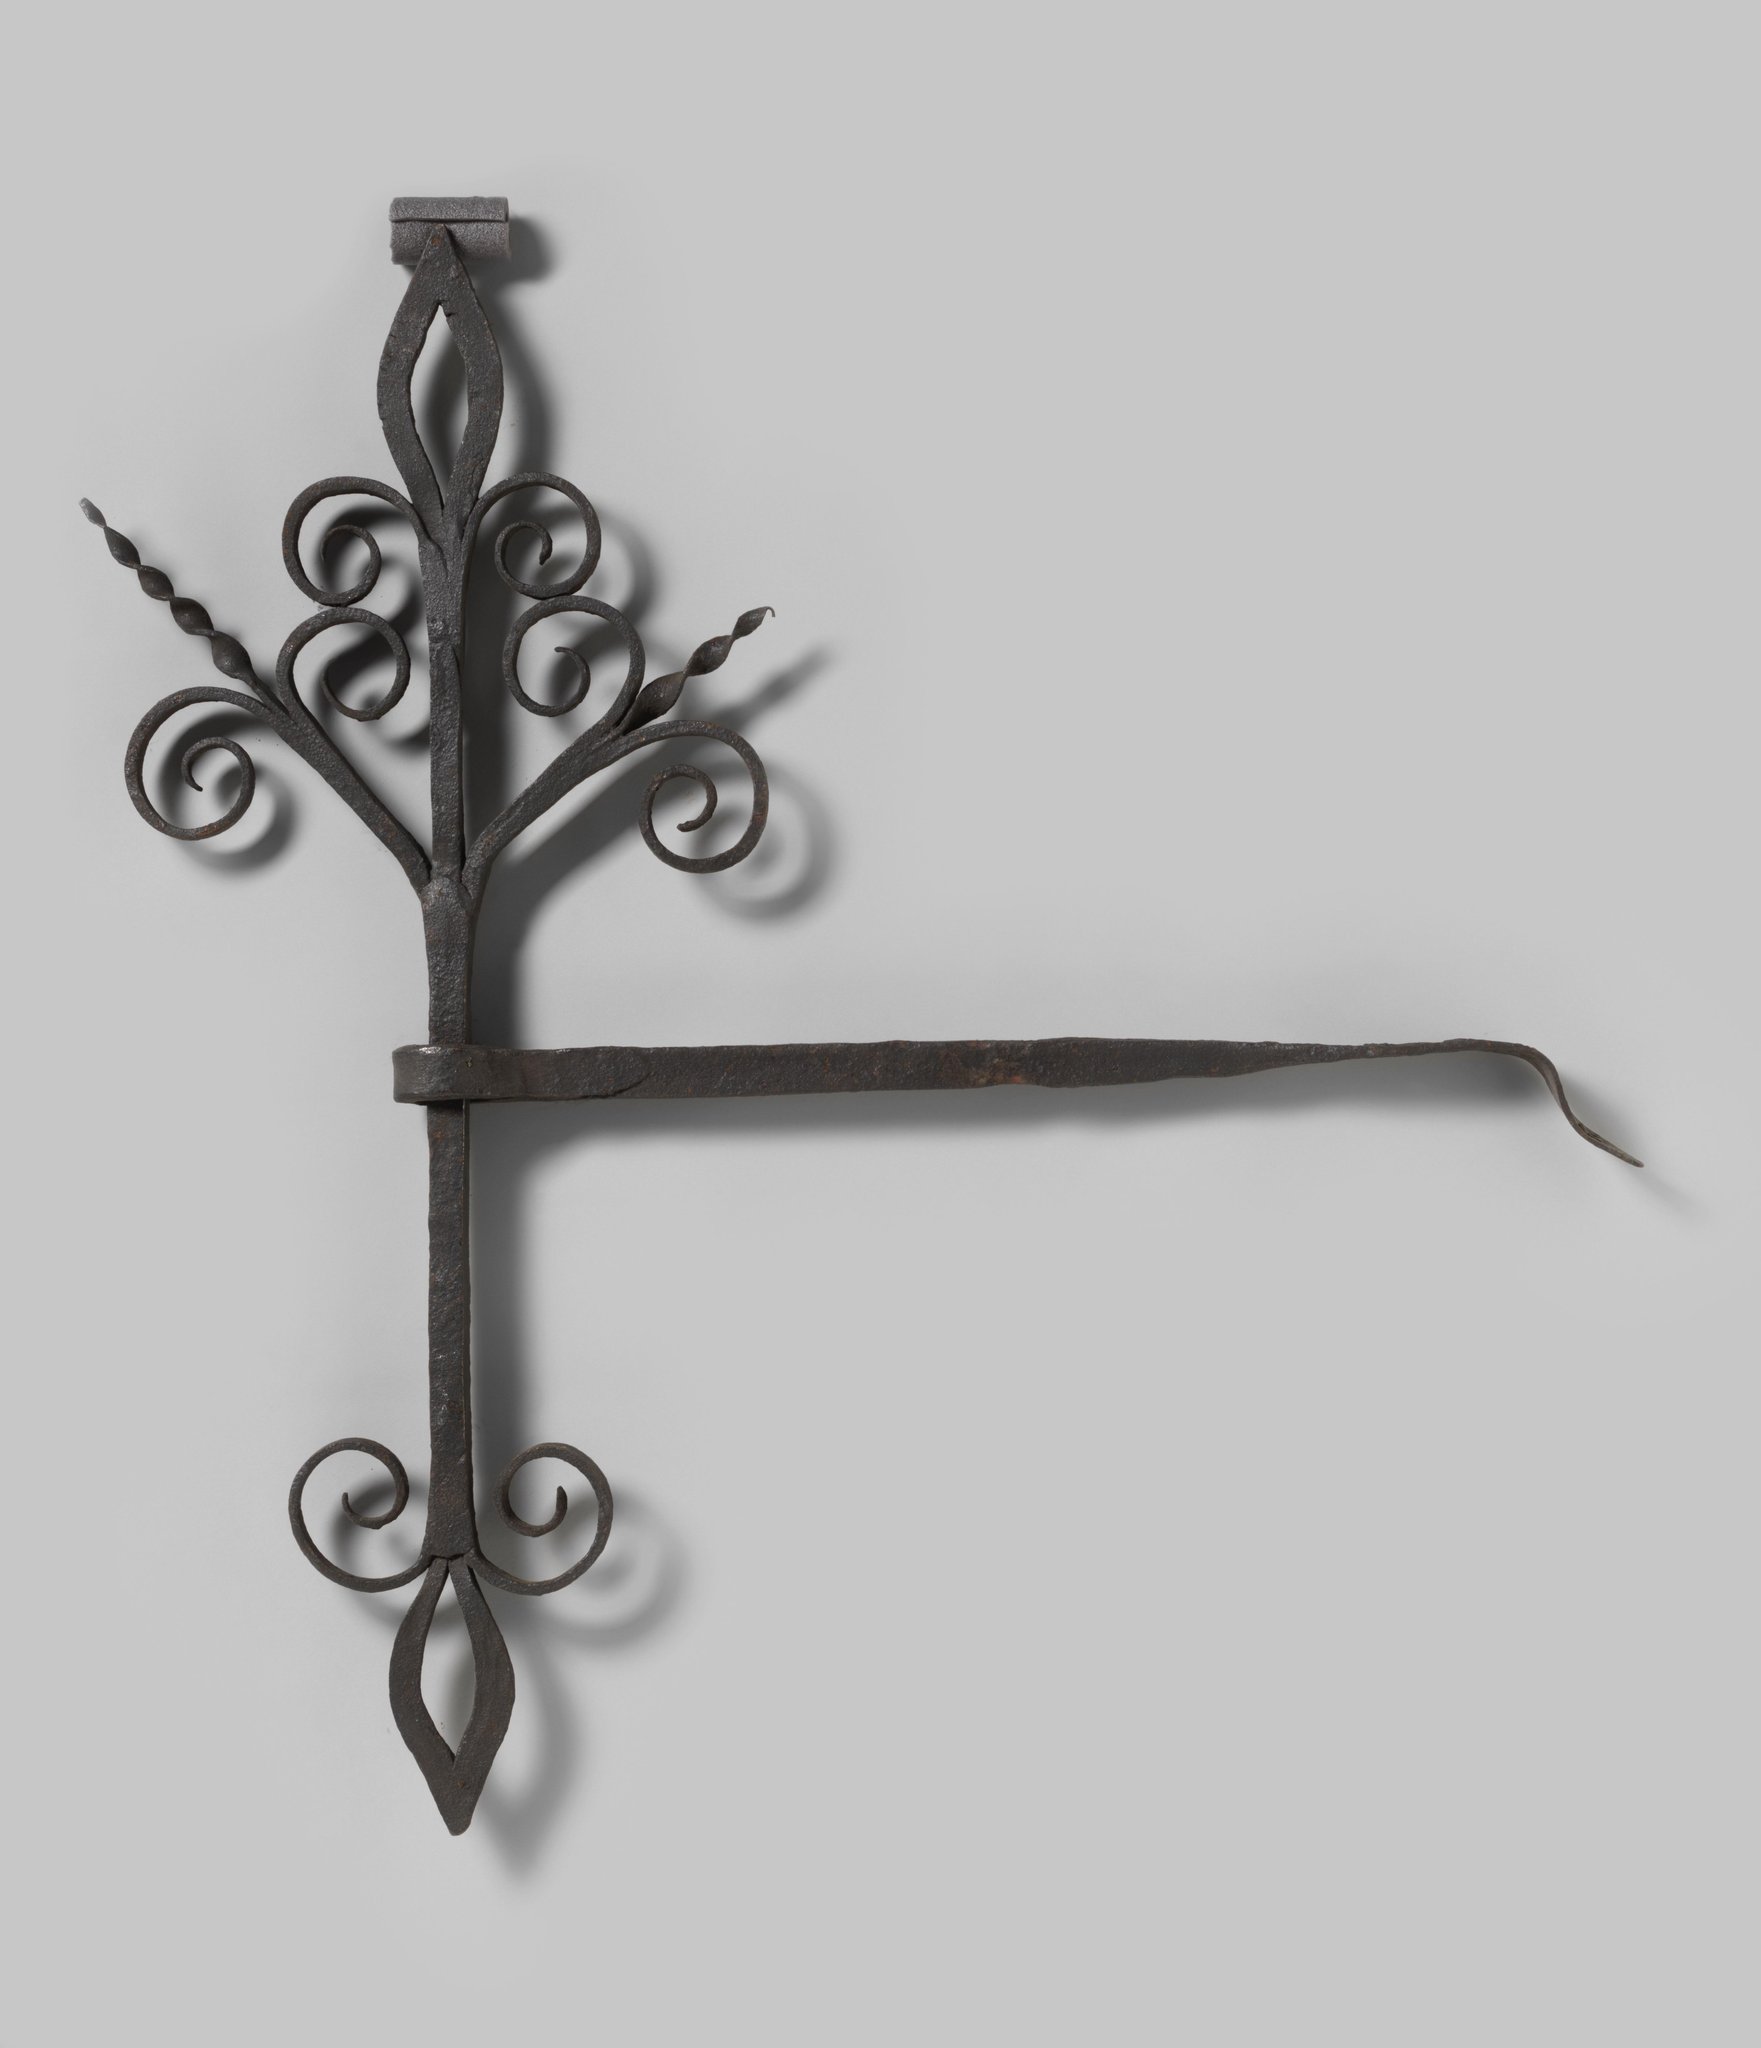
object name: beam anchor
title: Gevelanker, afkomstig van huis te Hattem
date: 1600-1699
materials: iron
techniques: forging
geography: hattem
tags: hattem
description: Een gevelanker van een gesloopt 17de eeuwse woonhuis te Hattem.